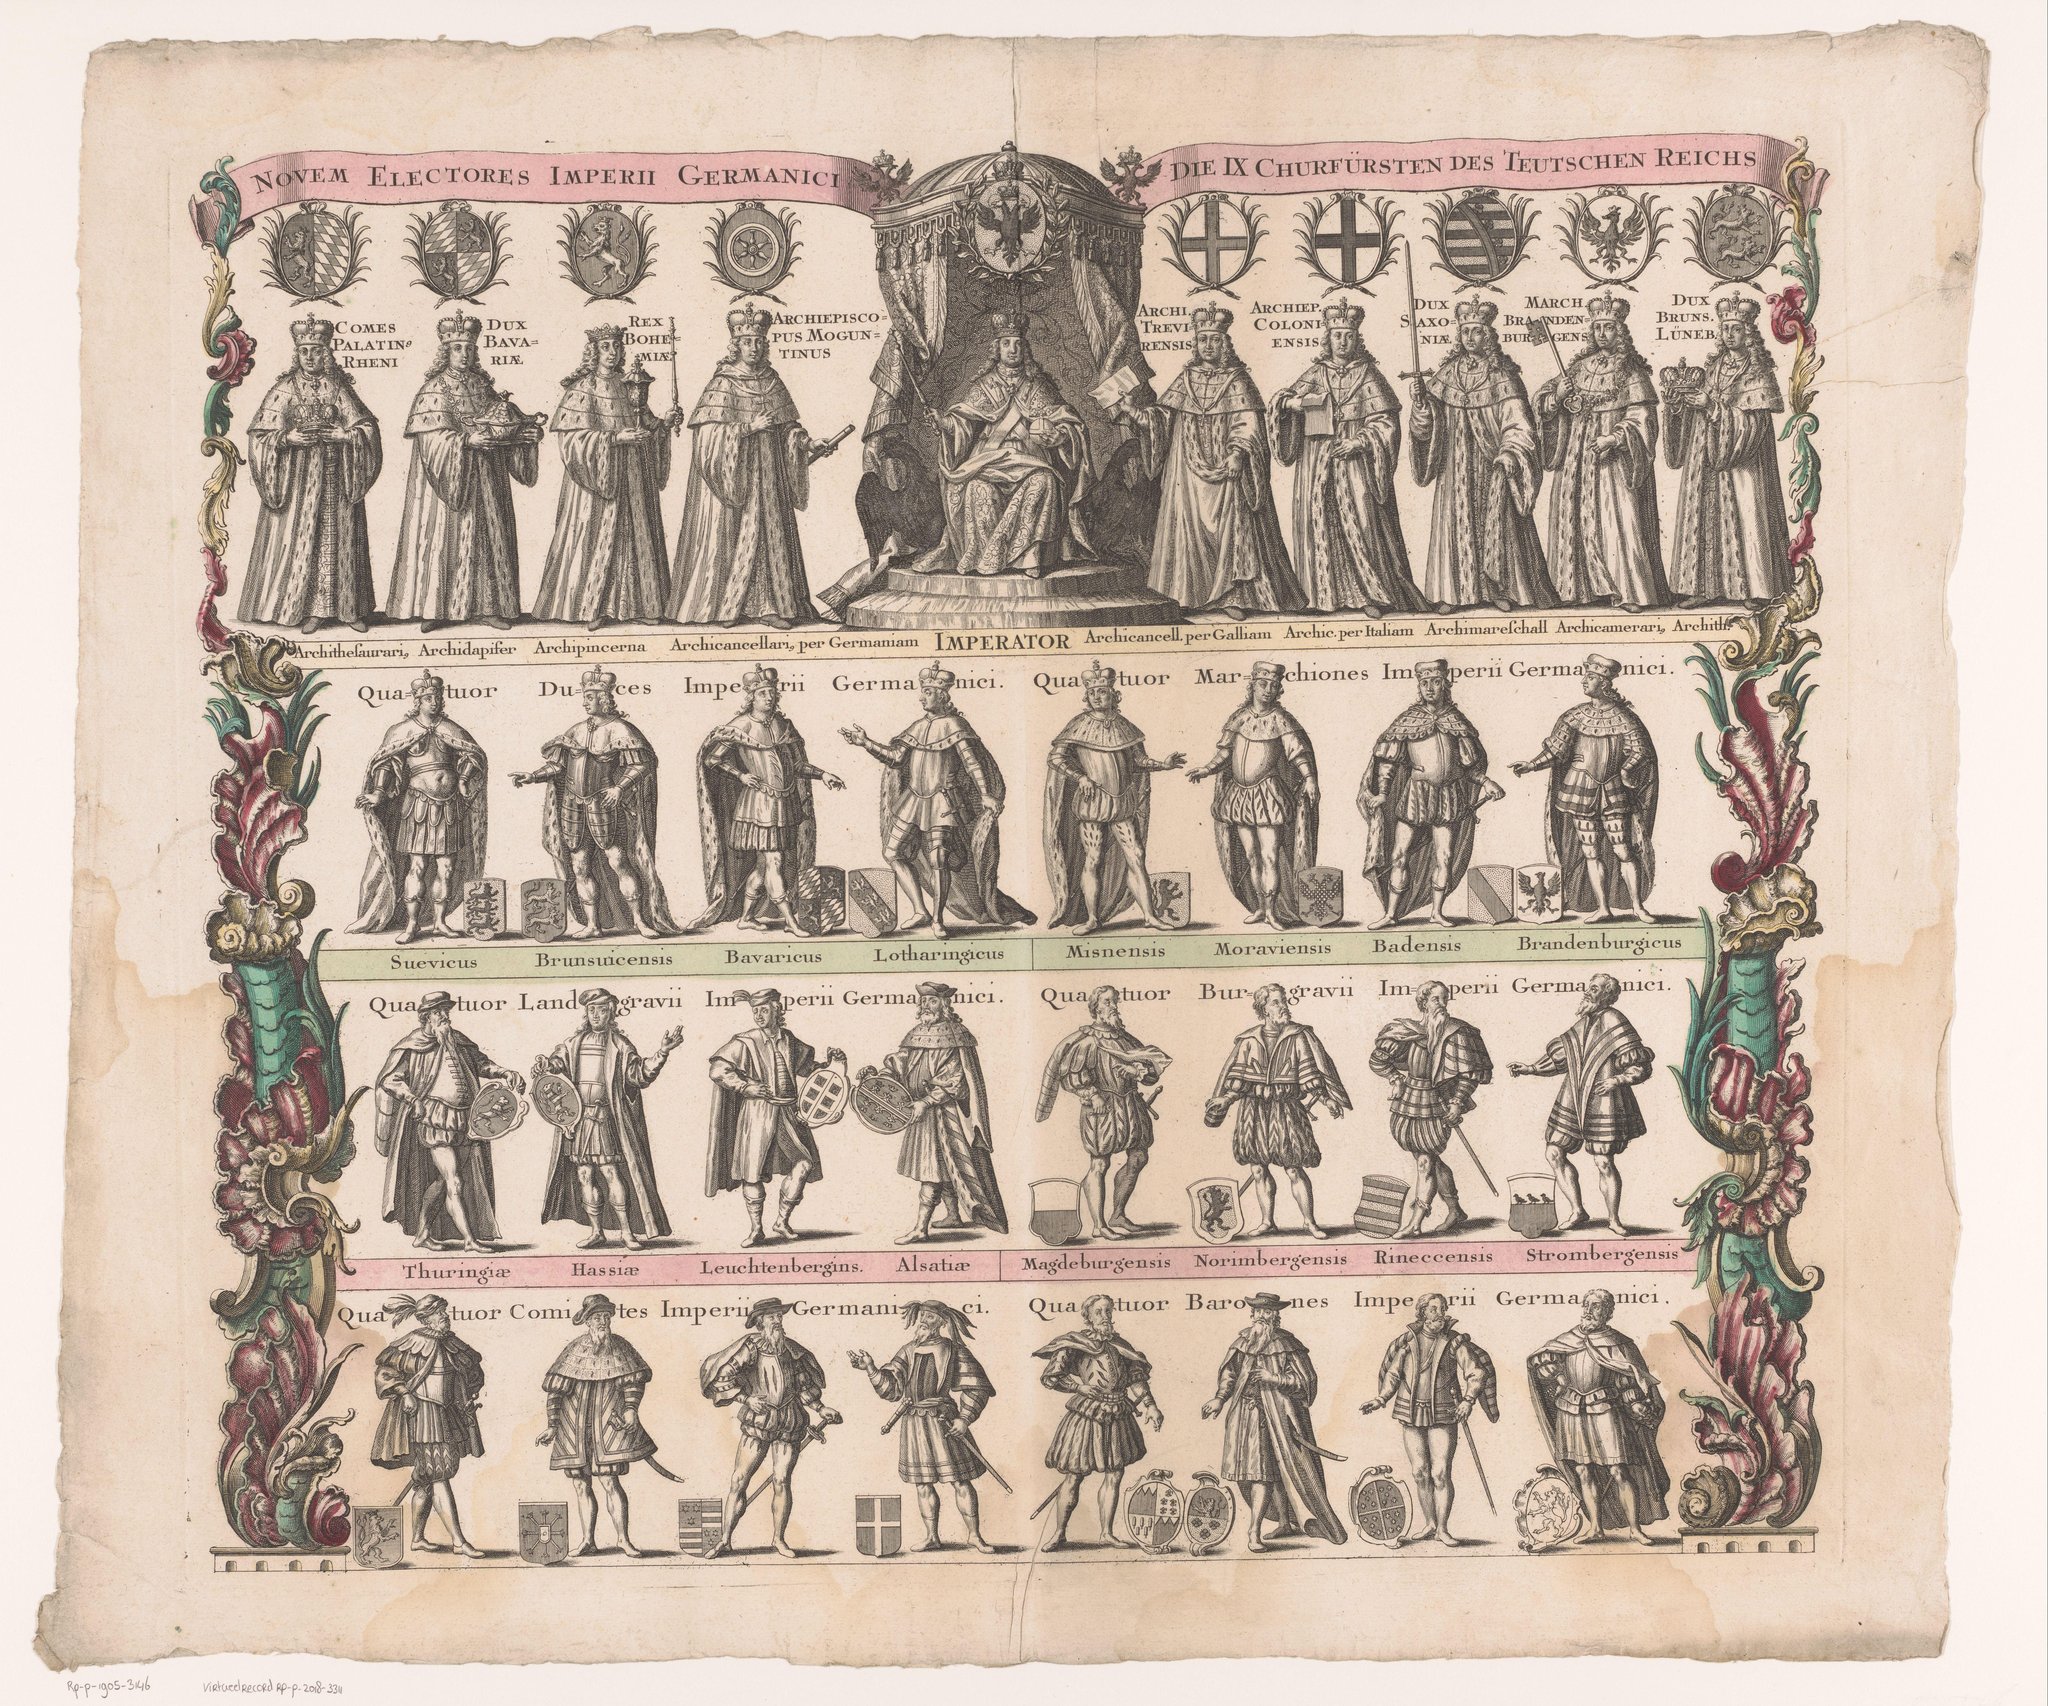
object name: print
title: De Institutione et Ordine Imperii Germanici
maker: matthaeus seutter (iii)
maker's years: 1678-1757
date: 1688-1757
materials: paper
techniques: etching, hand coloring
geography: augsburg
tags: governmental and representative bodies, hierarchical order, emperor, organization, functionaries and dignitaries in roman catholic church; clergy in general, armorial bearing, heraldry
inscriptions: collector's mark: Lugt 2228